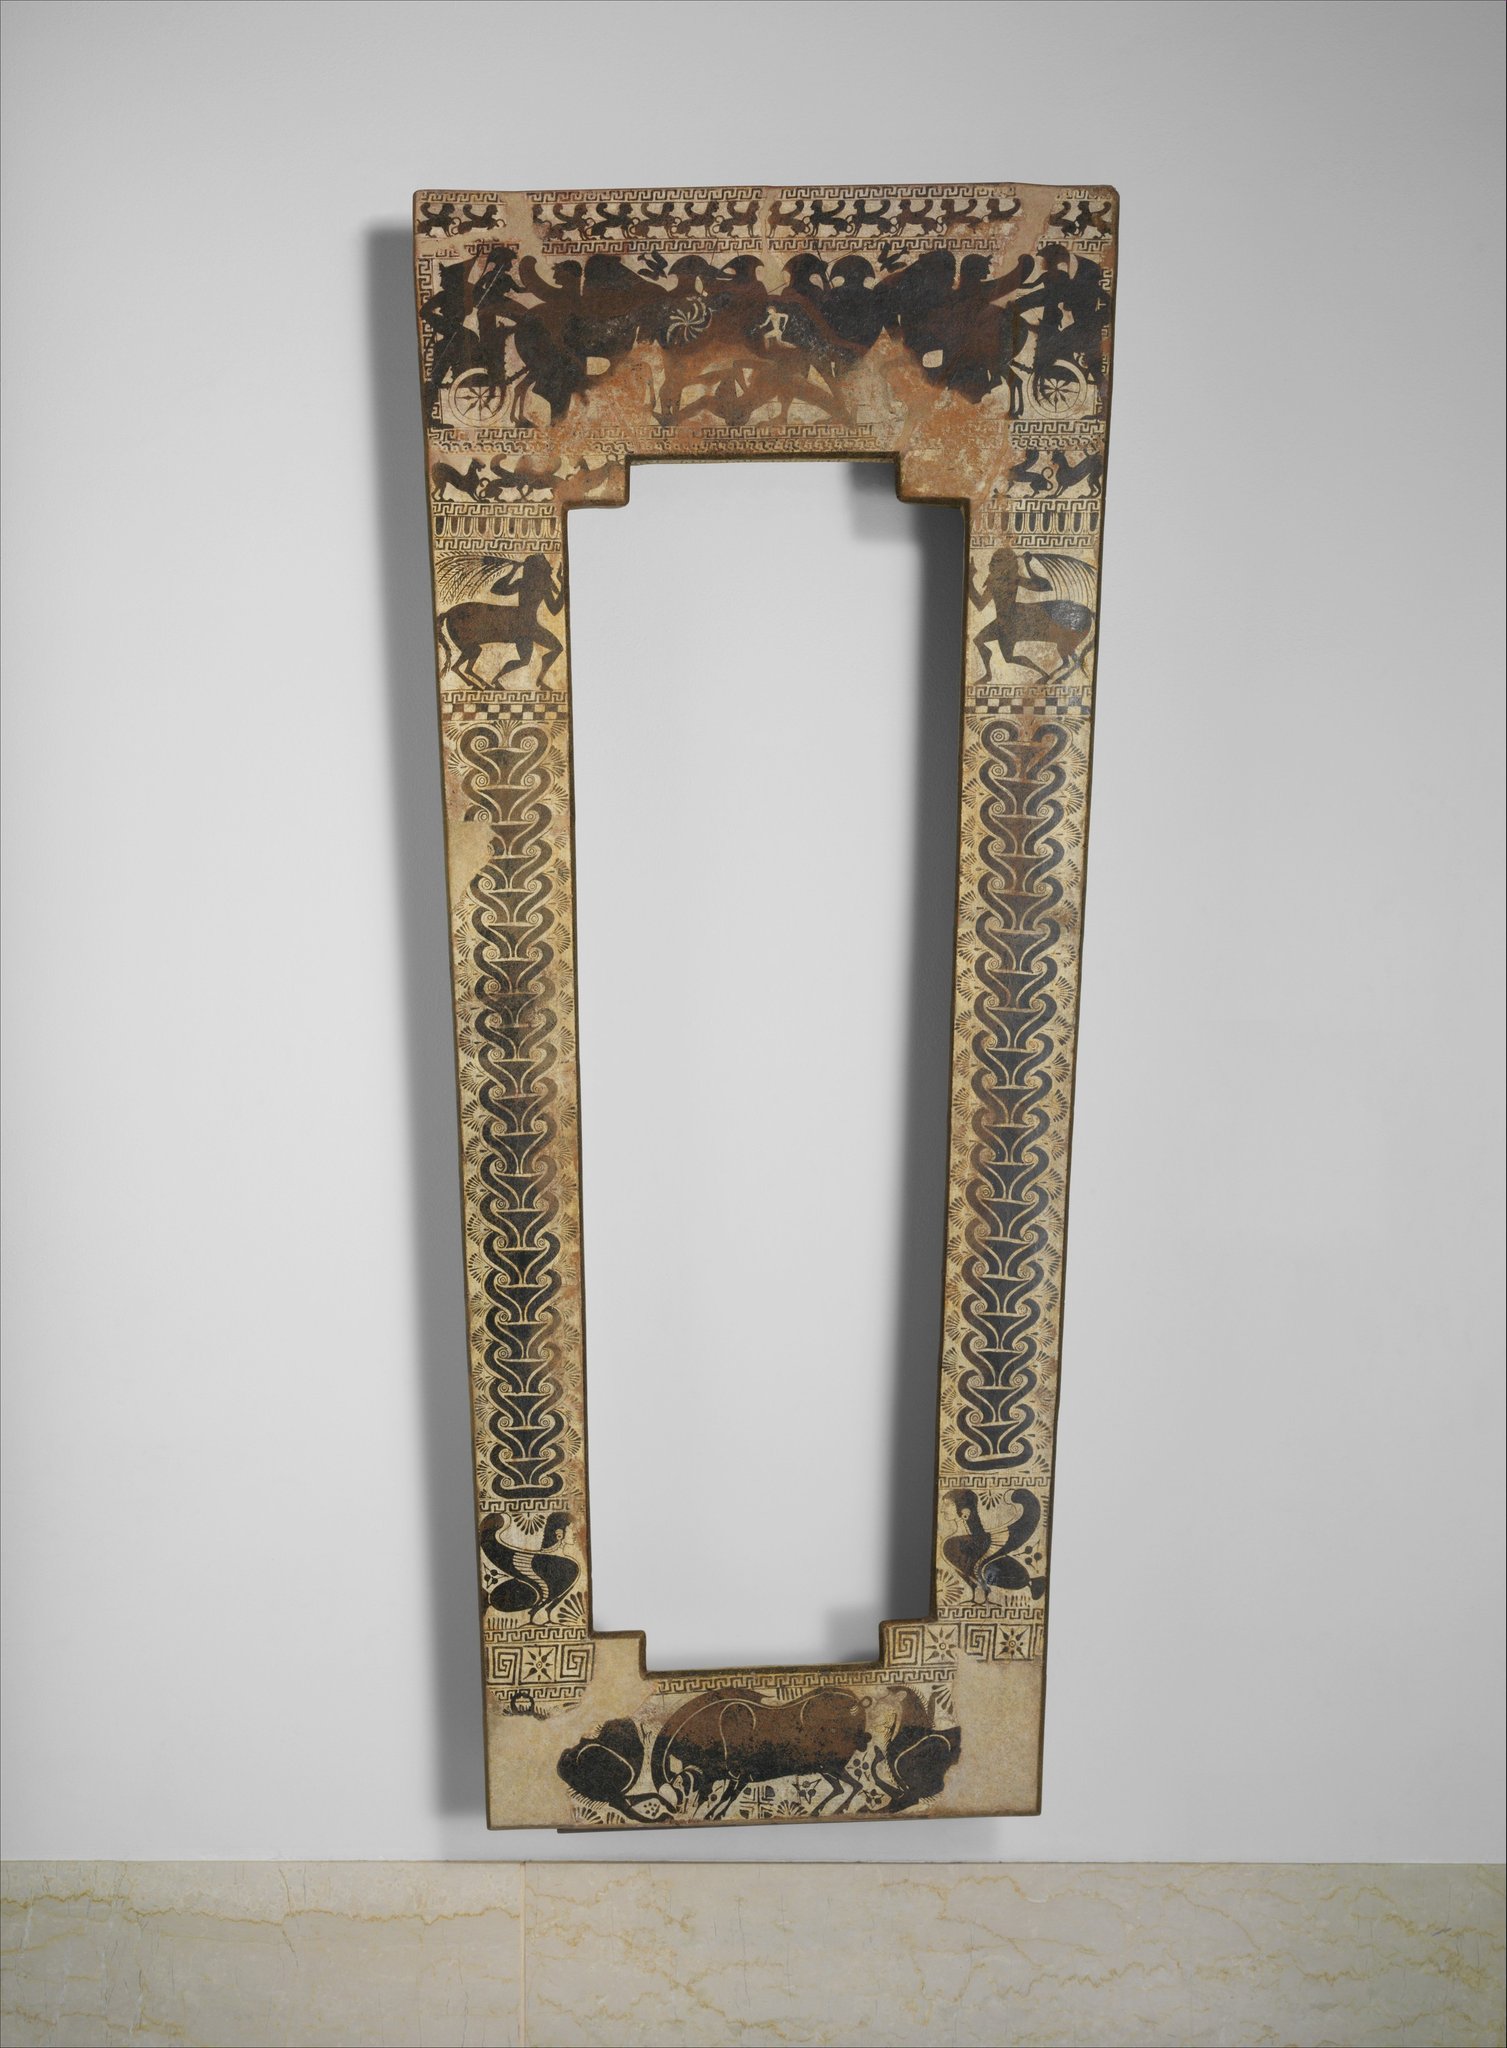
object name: sarcophagus rim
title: Terracotta sarcophagus rim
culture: greek, east, clazomenian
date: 525-501 BCE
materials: terracotta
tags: battles,centaurs,boars,lions